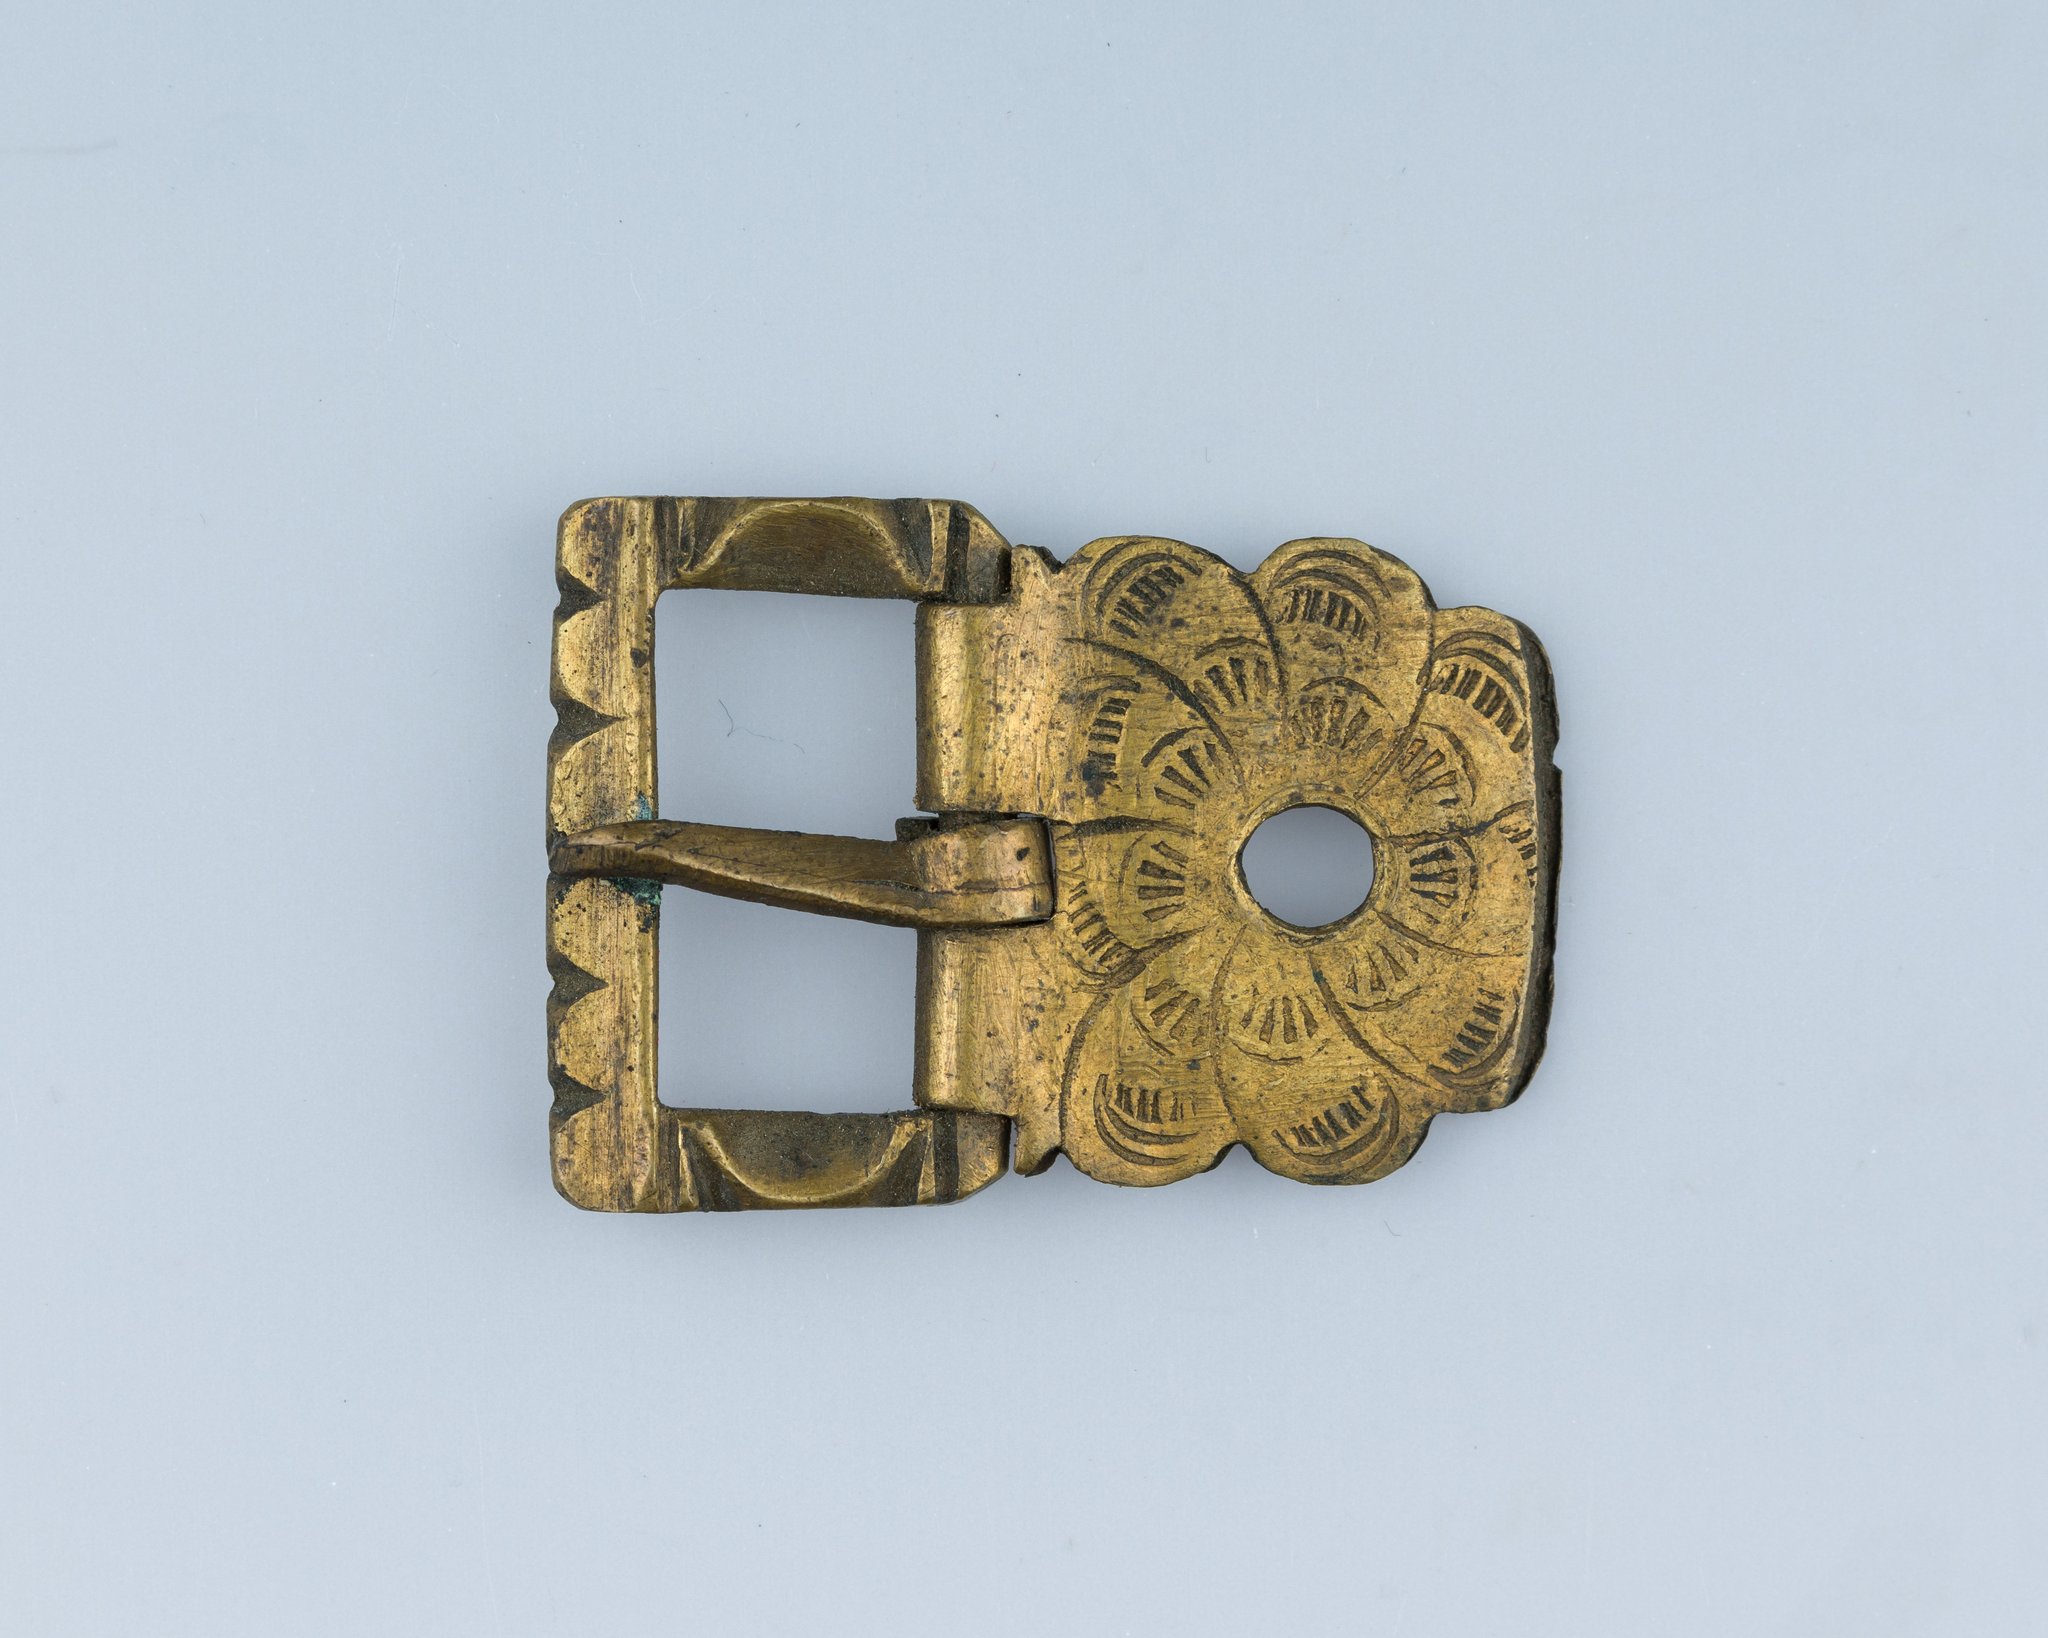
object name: buckle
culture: german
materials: brass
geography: germany